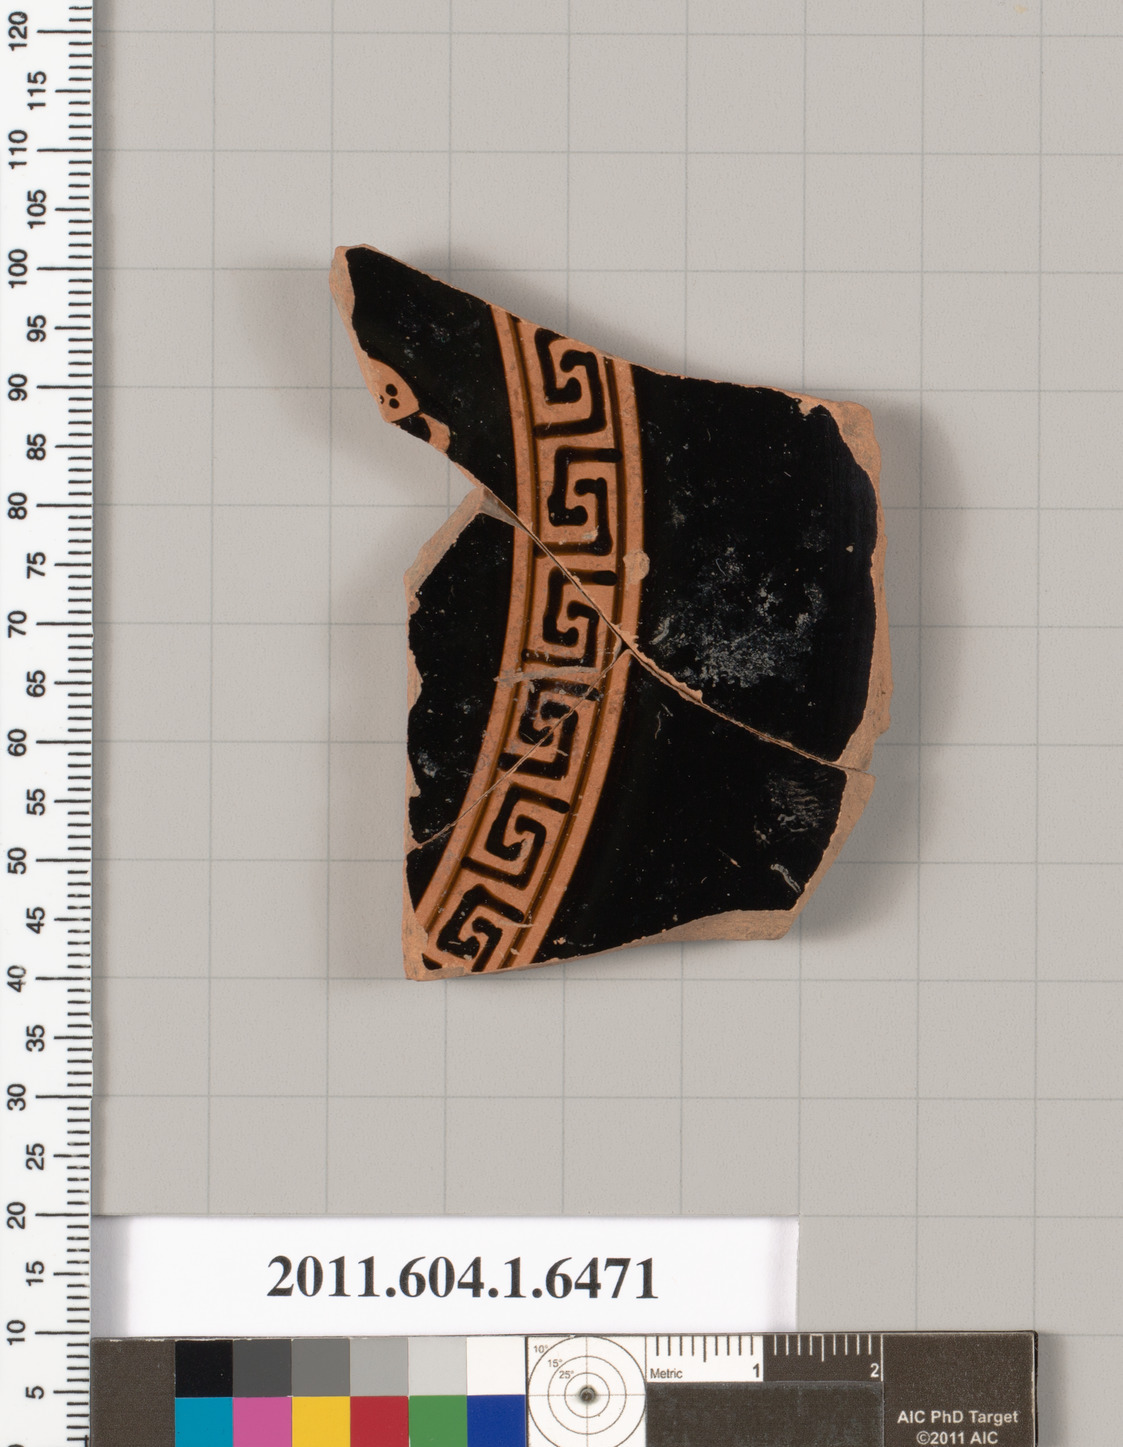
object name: kylix fragment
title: Terracotta fragment of a kylix (drinking cup)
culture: greek, attic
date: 490-480 BCE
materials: terracotta